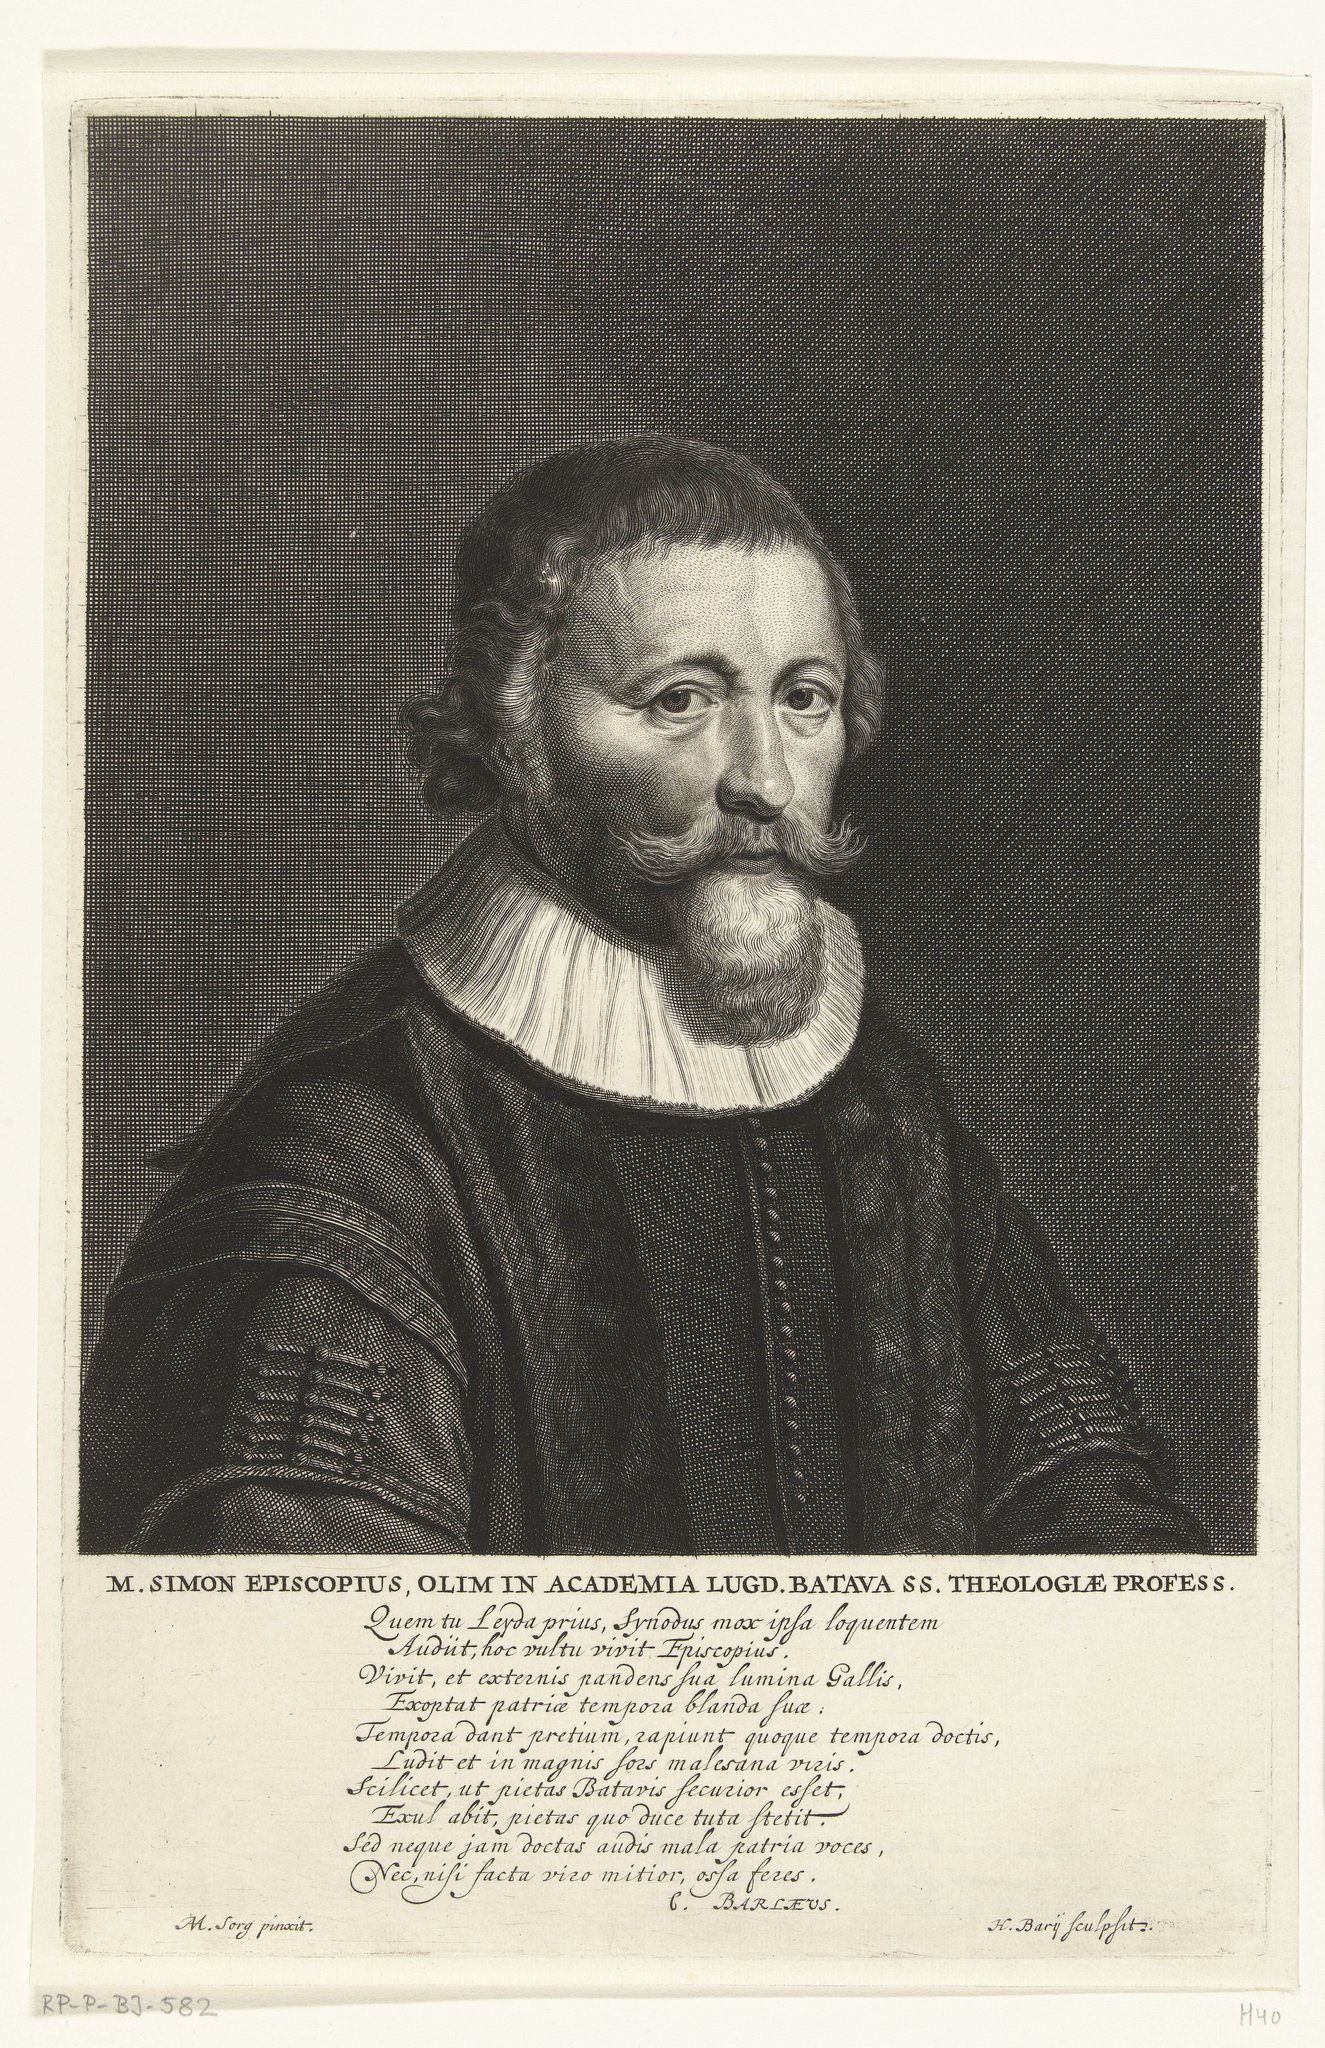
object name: print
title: Portret van Simon Episcopius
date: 1657-1707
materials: paper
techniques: engraving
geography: netherlands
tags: amsterdam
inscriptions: collector's mark: Lugt 240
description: Borstbeeld van Simon Episcopius, onder de voorstelling zijn naam en titels en een Latijns vers van tien regels.